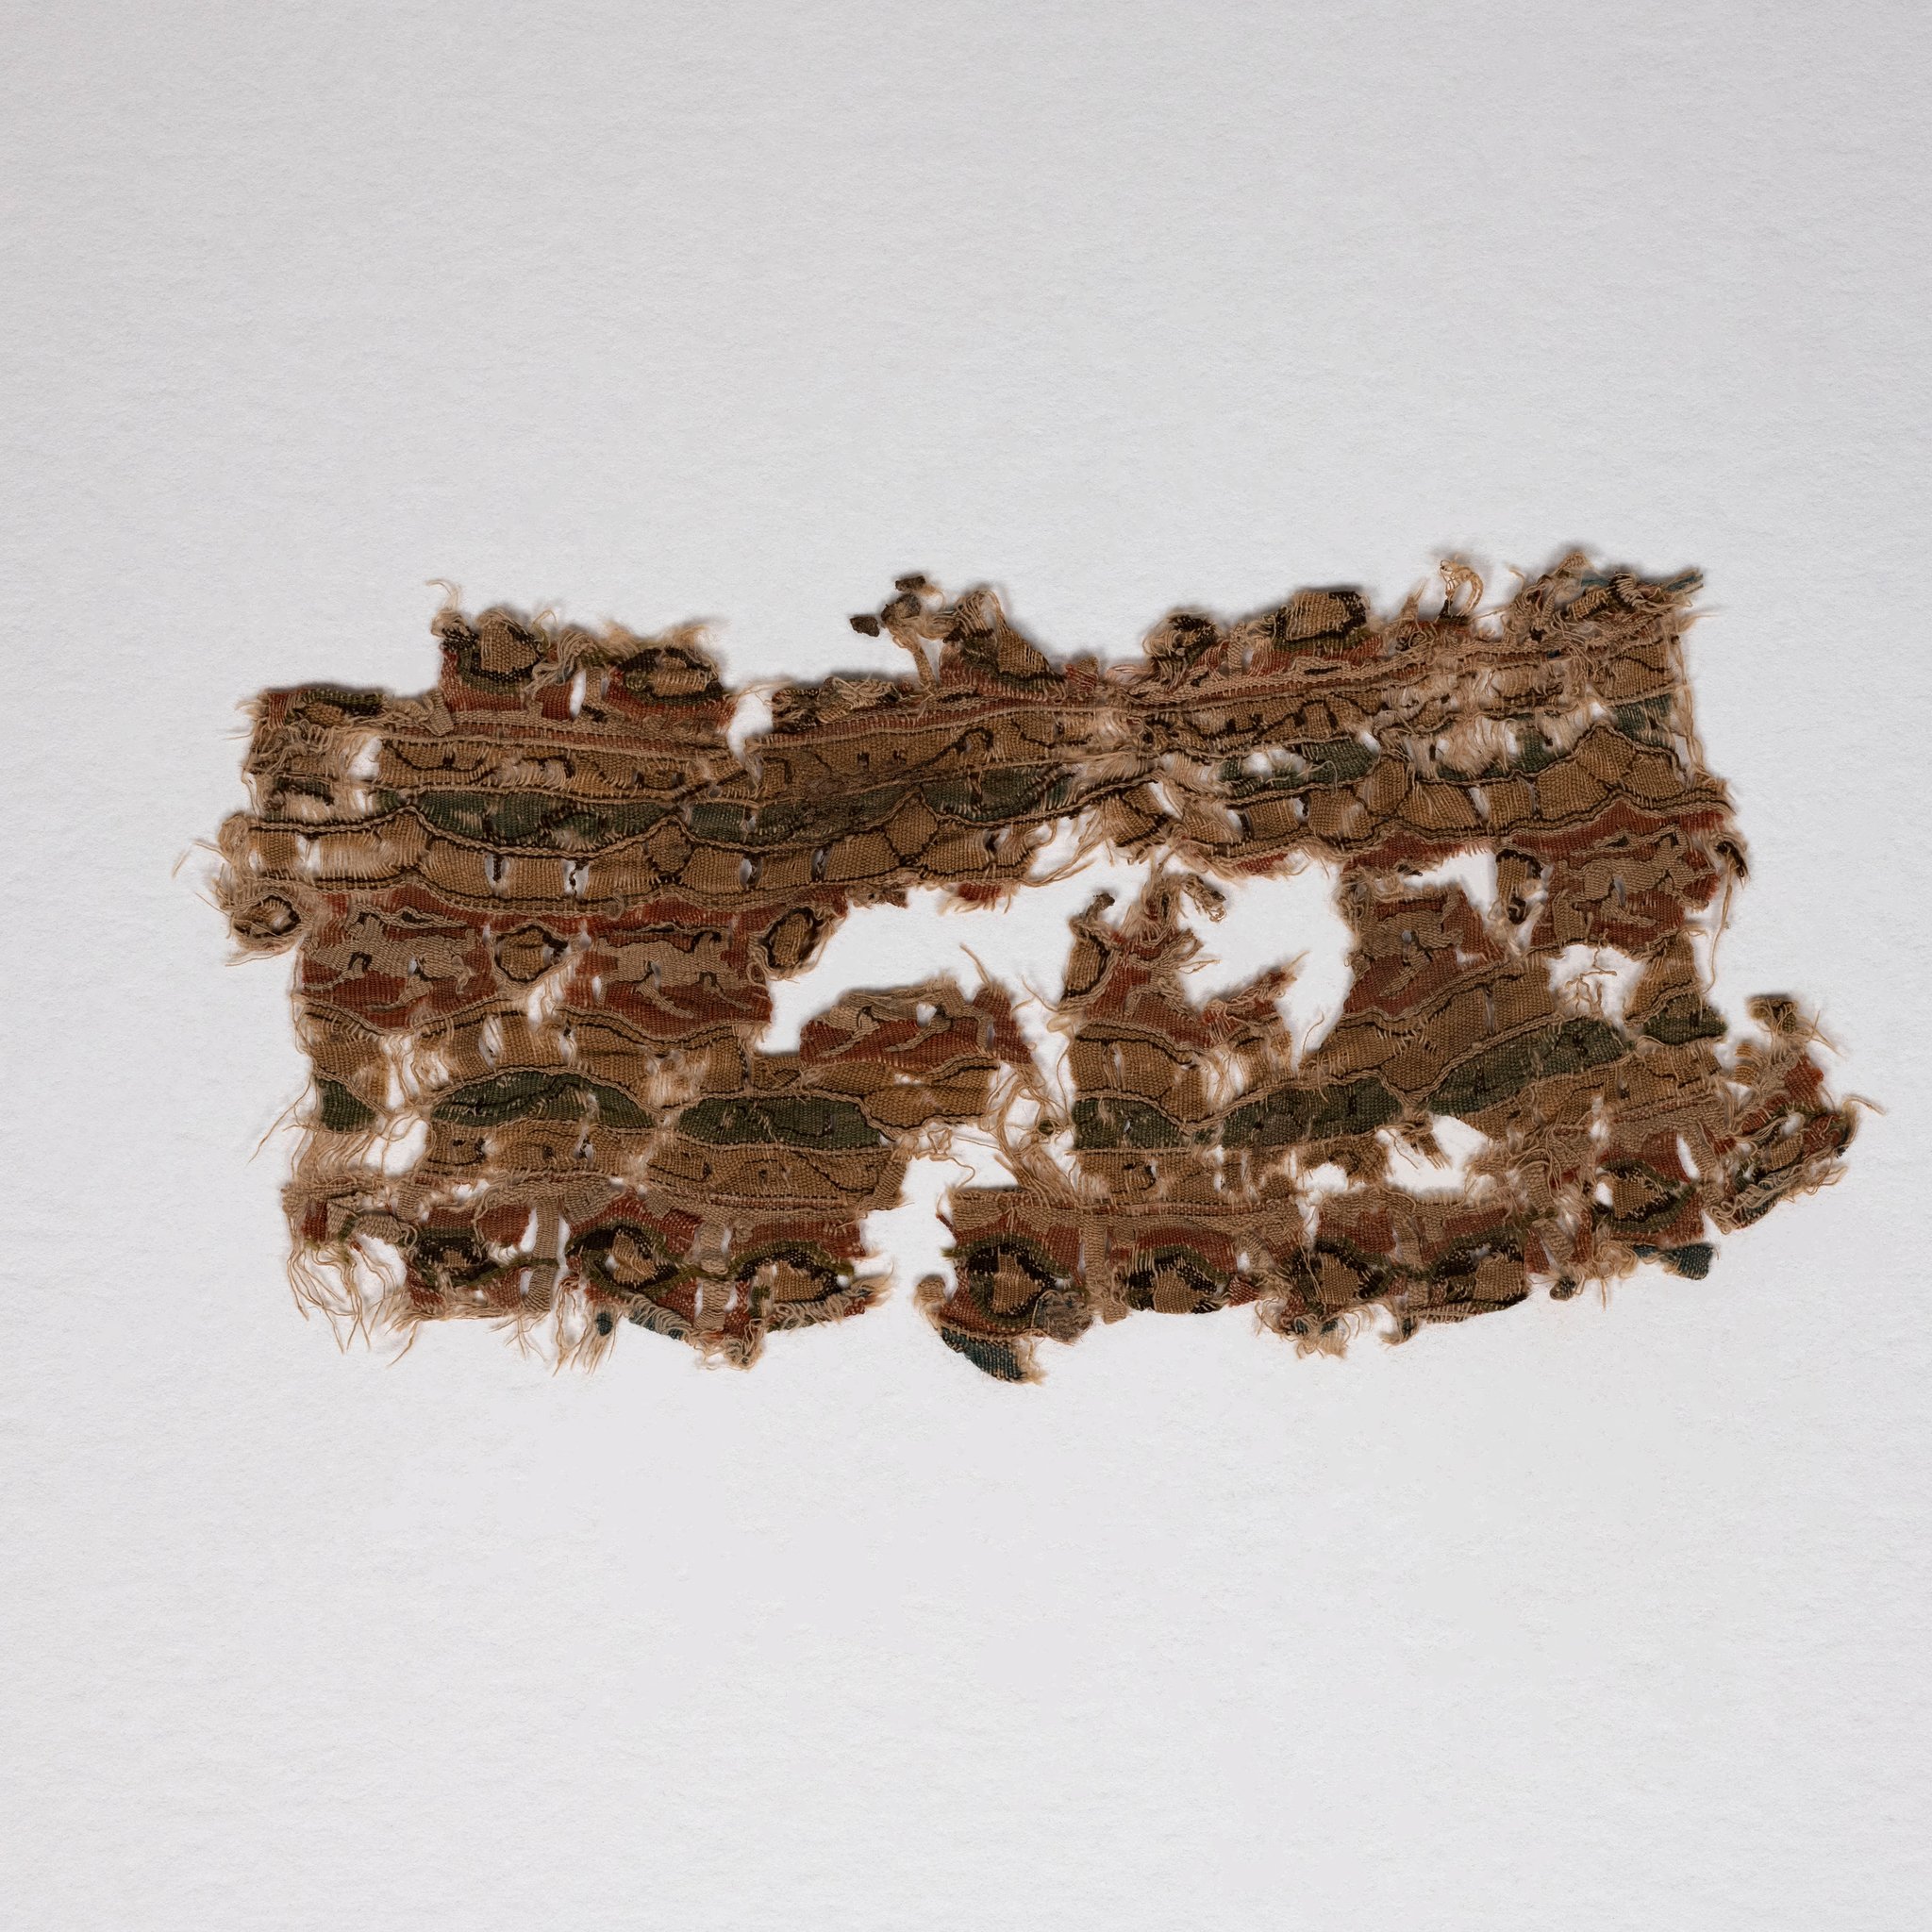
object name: textile fragment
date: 1034-1066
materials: cotton, silk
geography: egypt